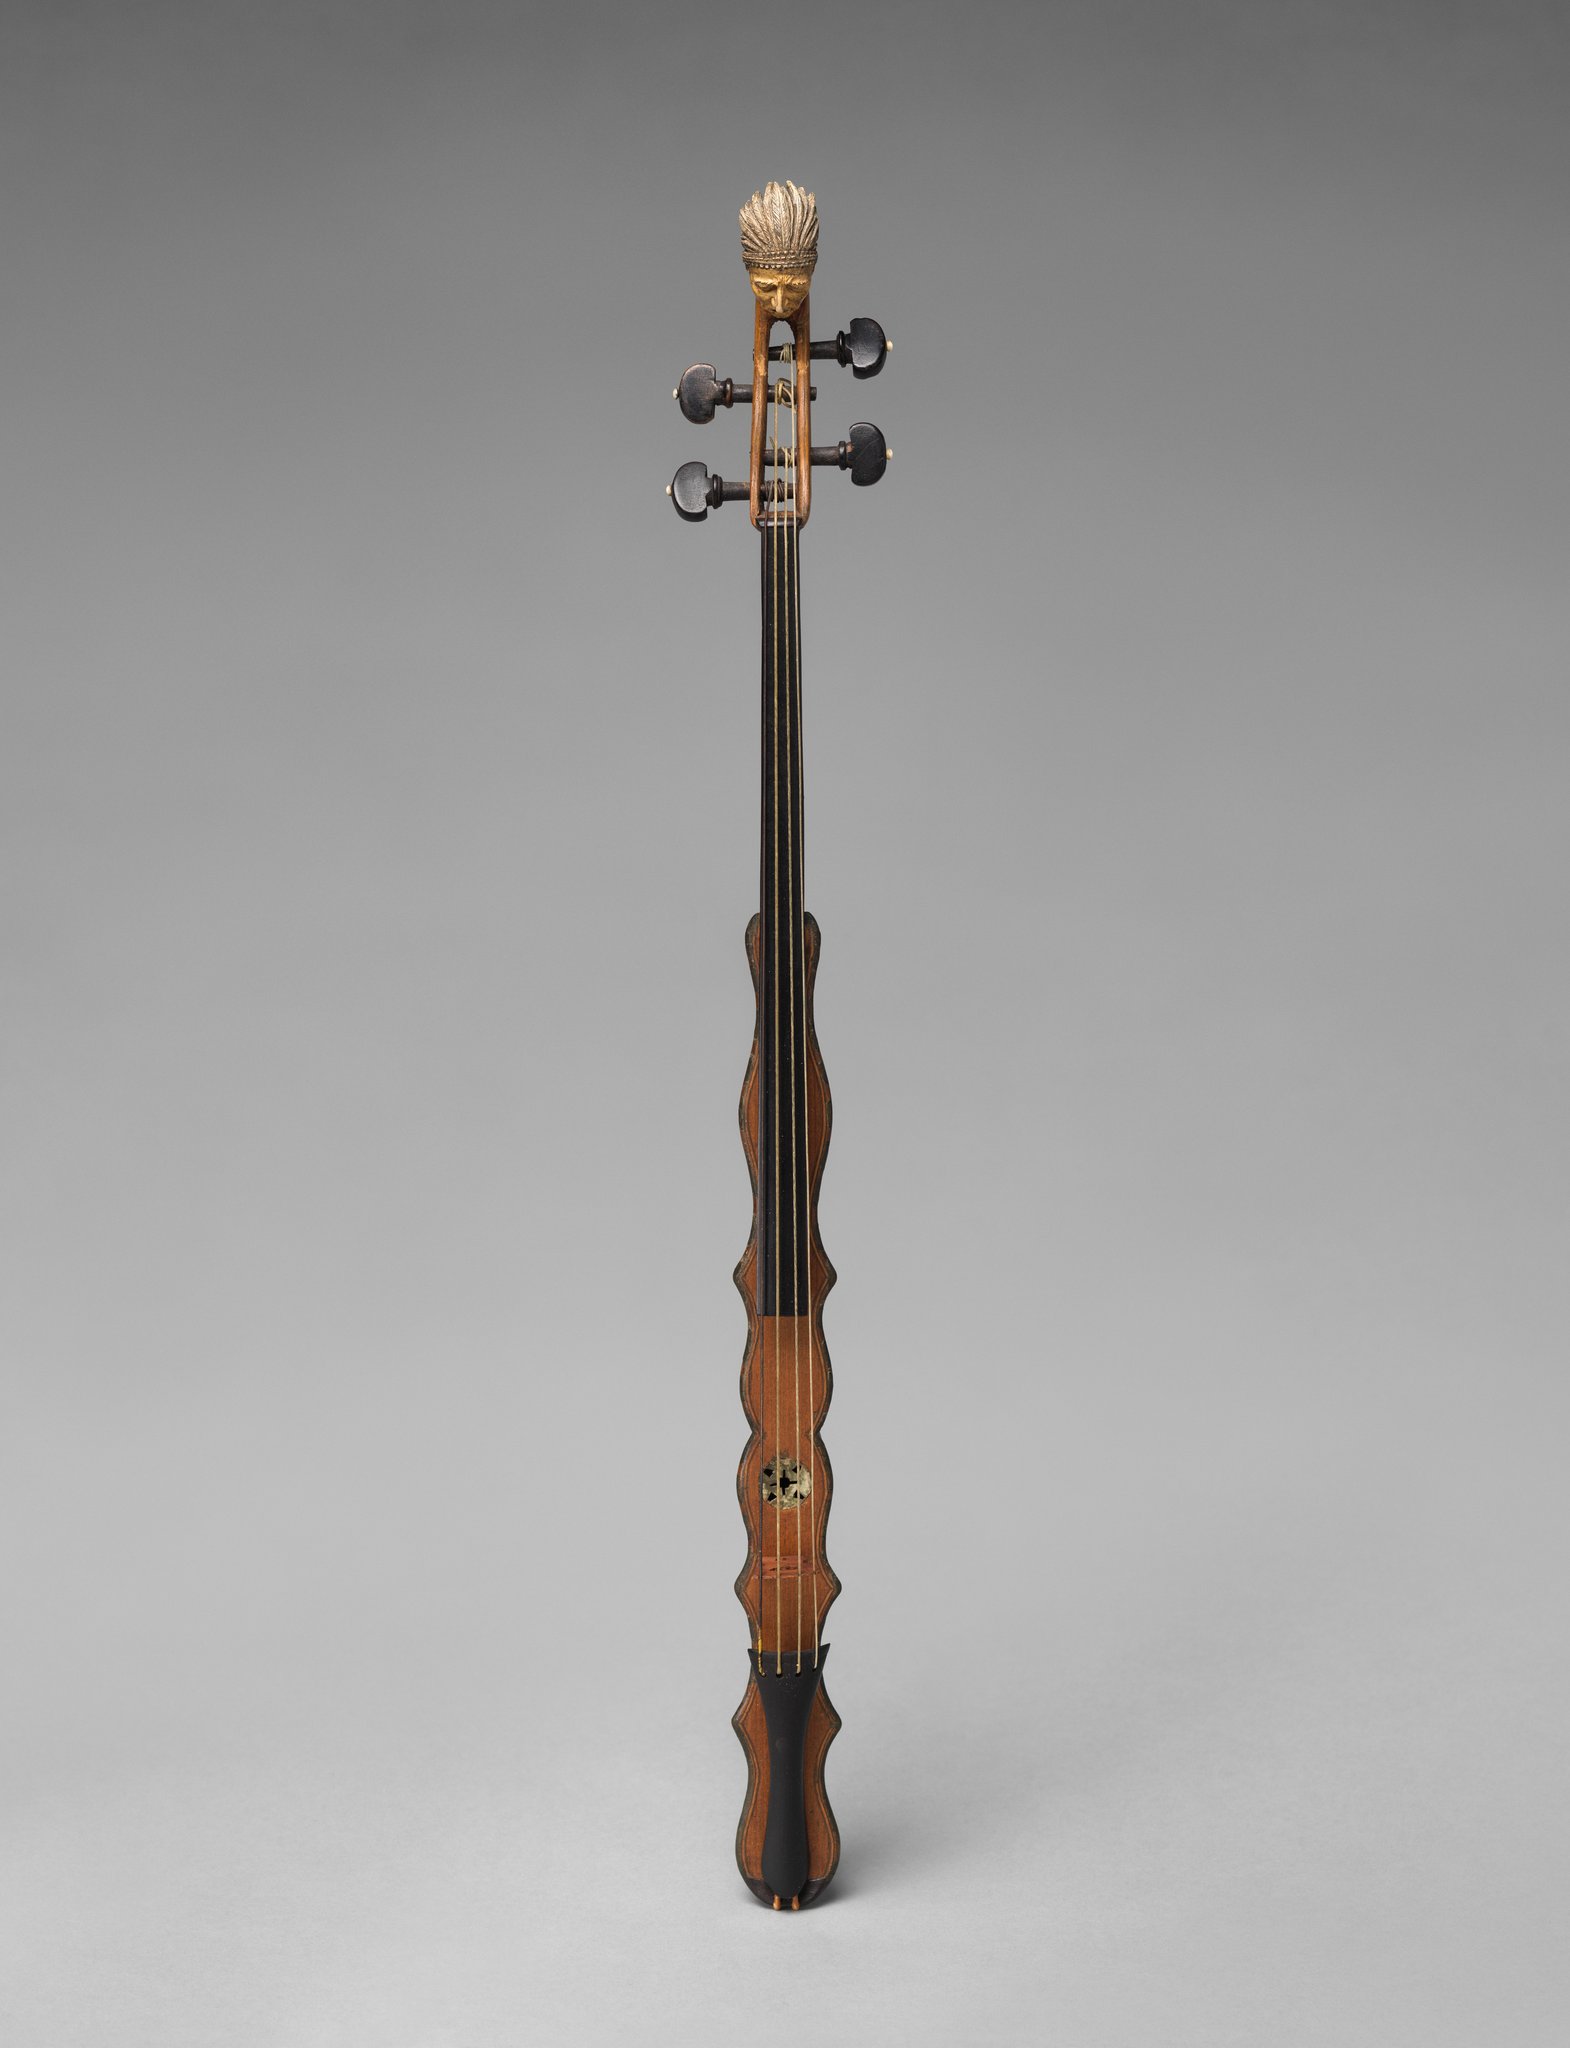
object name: pochette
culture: european or american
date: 1800-1900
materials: wood, metal